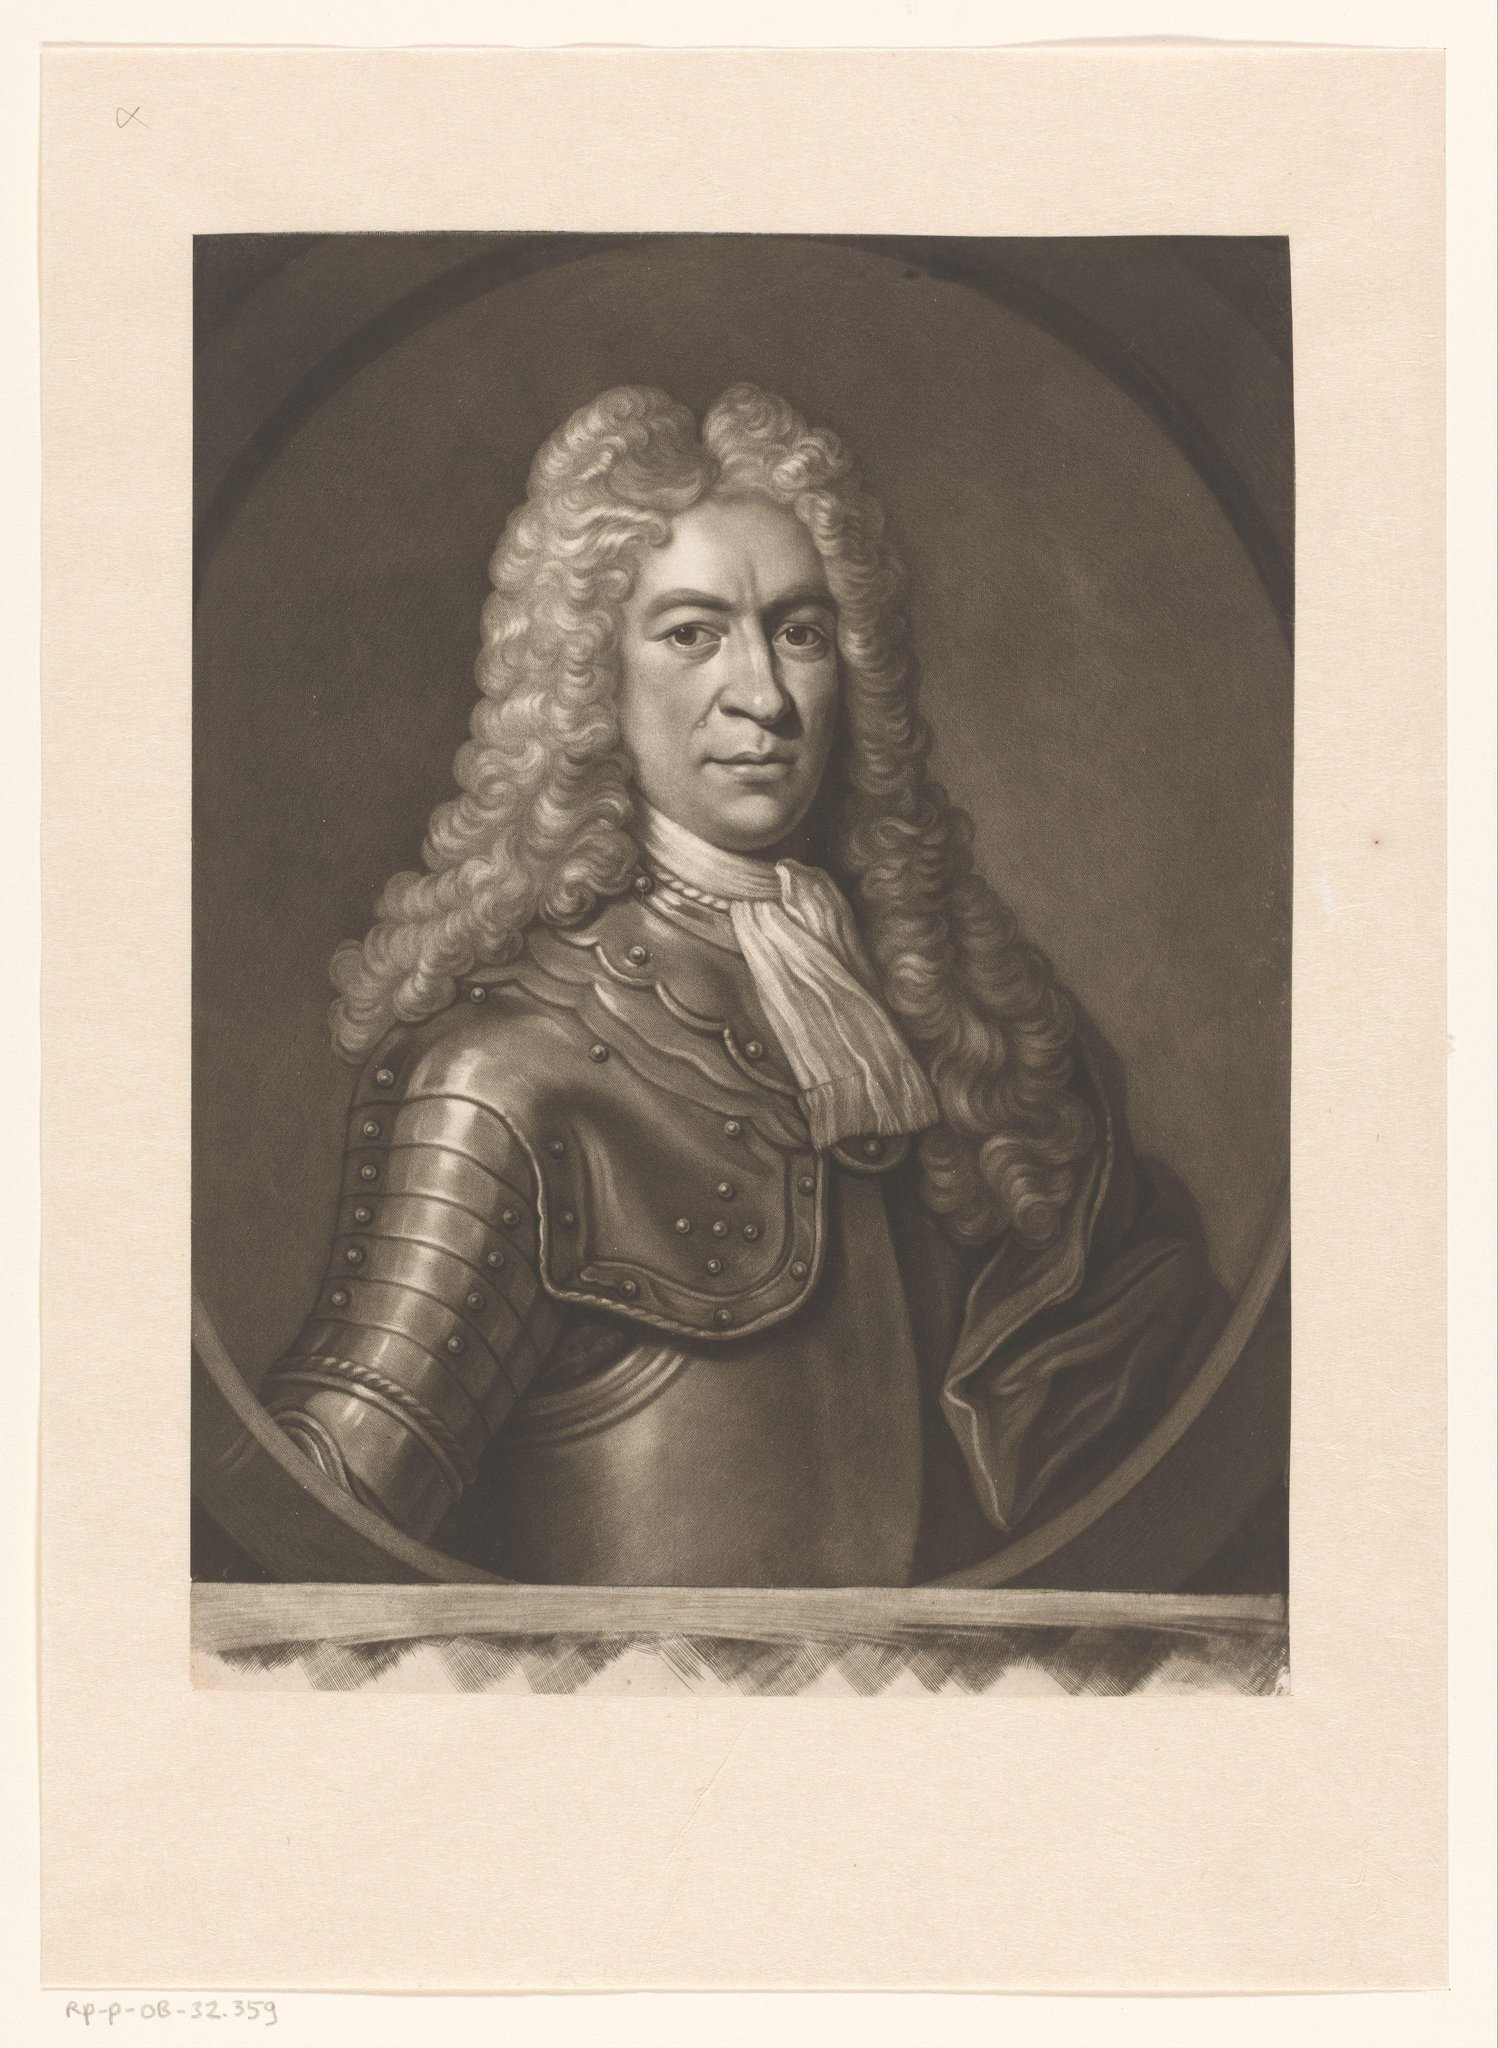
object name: print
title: Portret van John Armstrong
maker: james mcardell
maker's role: print maker, publisher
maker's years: 1728-1765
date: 1753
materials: paper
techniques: mezzotint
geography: london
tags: commander-in-chief, general, marshal, historical persons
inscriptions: collector's mark: Lugt 240